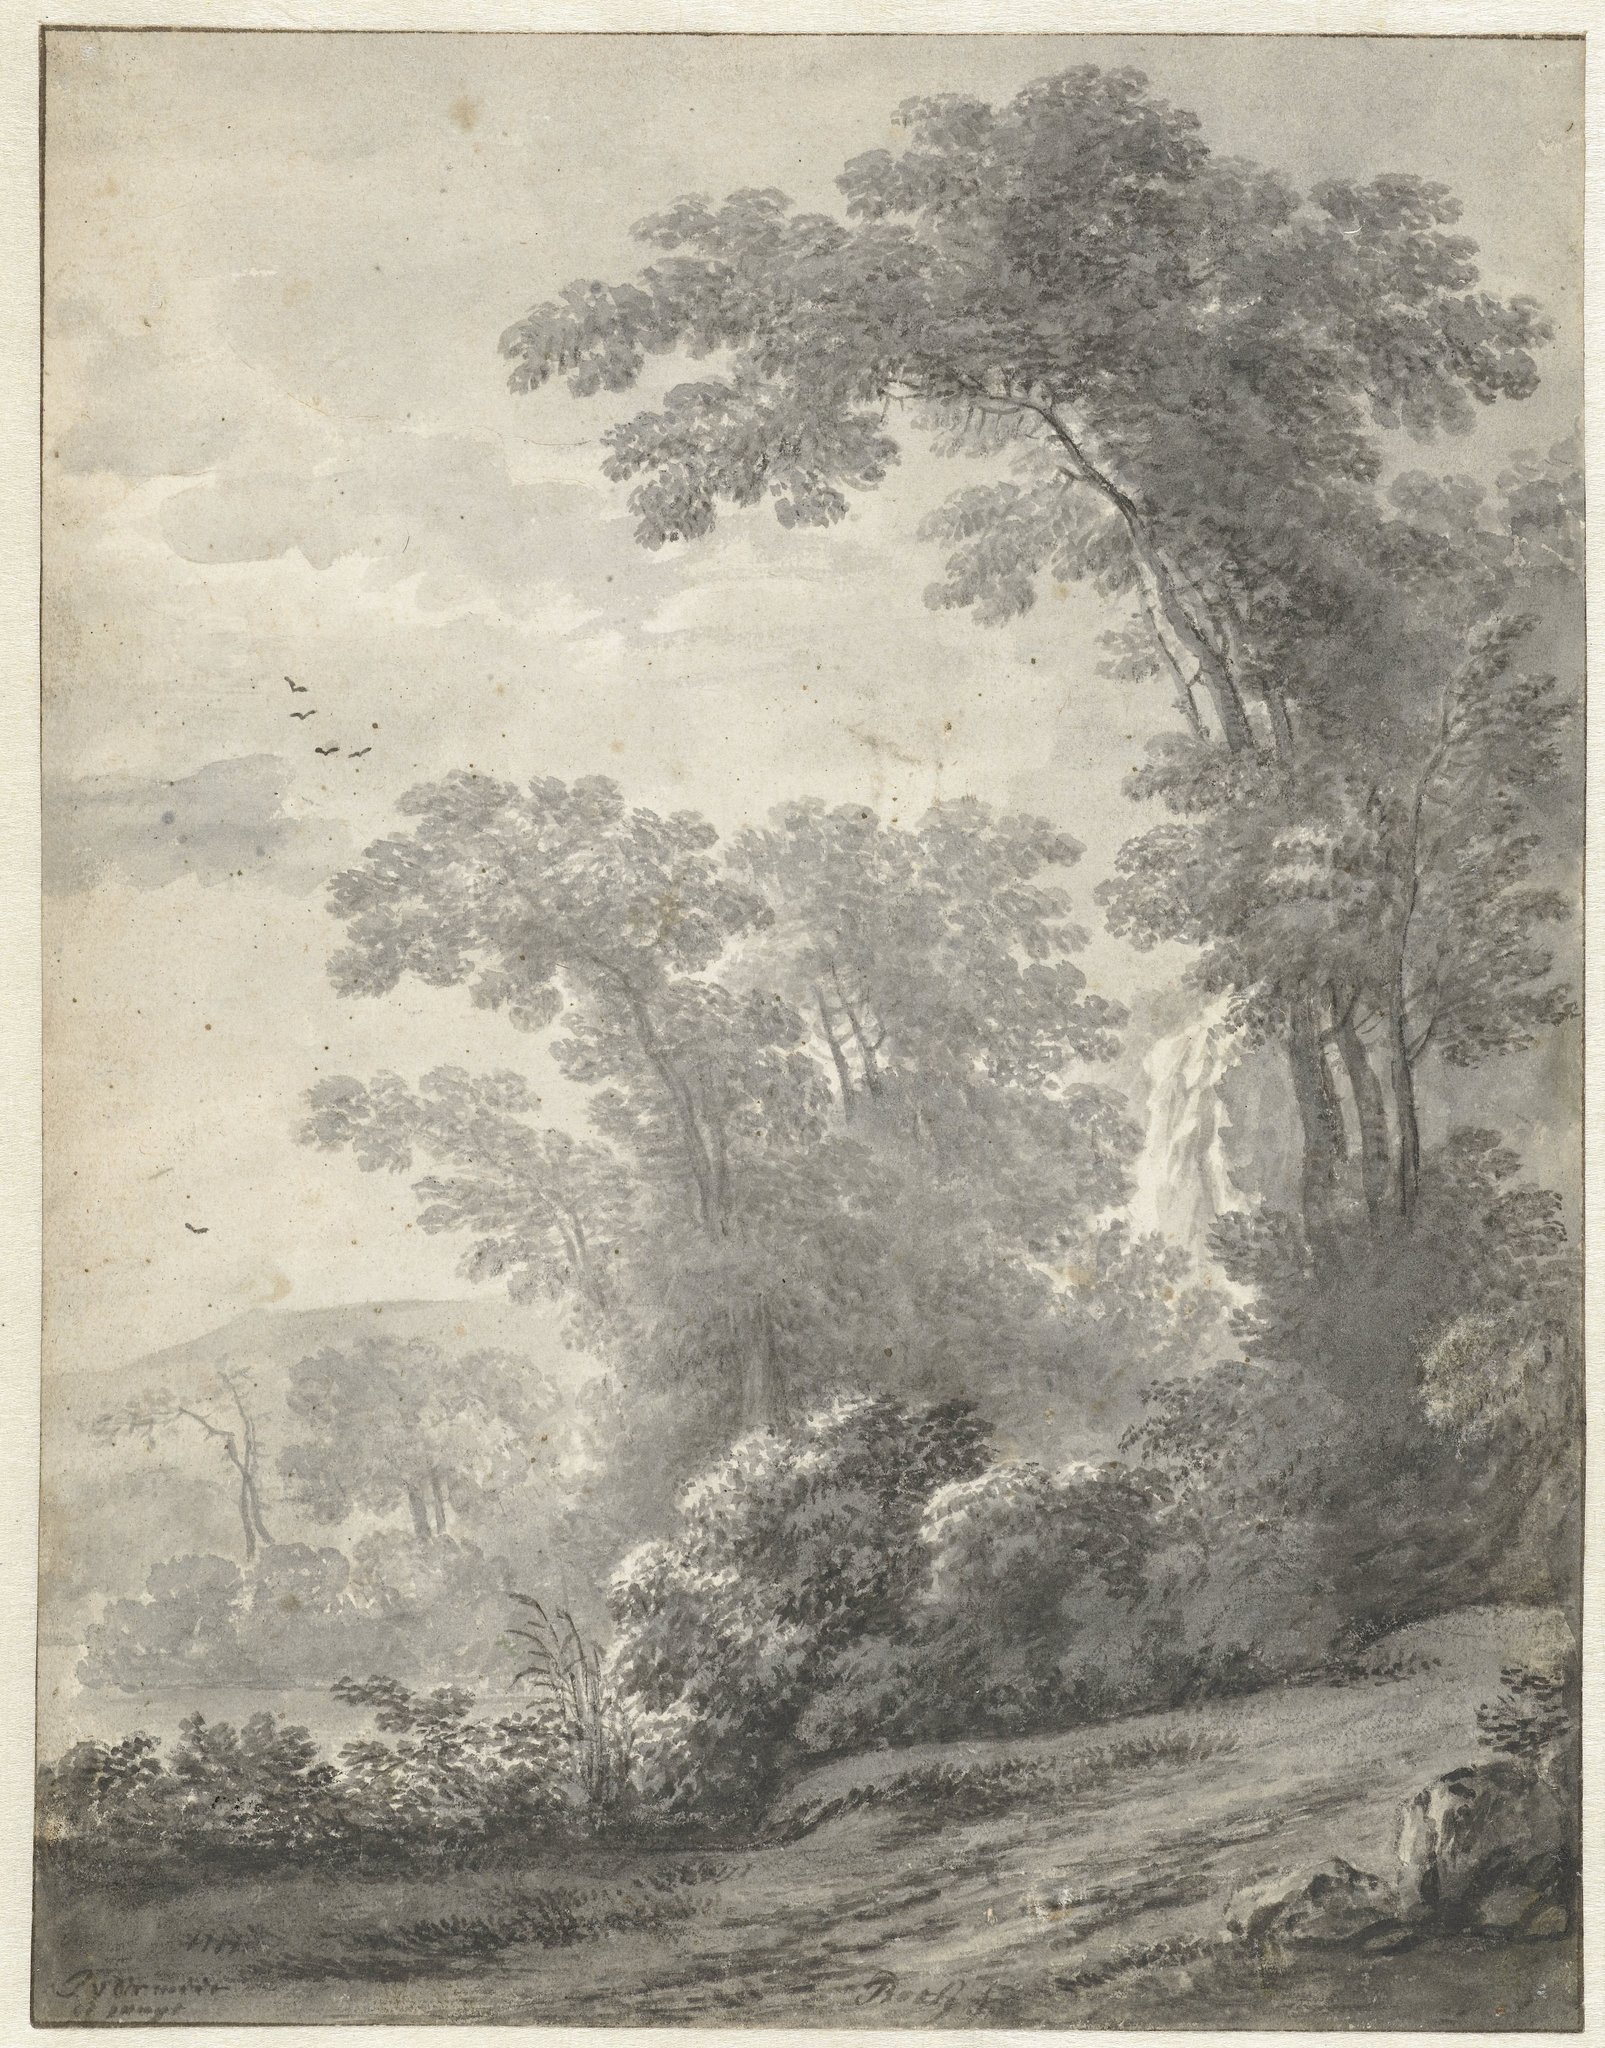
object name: drawing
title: Mountain Landscape with Trees near a River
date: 1700-1705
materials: chalk, graphite, ink, paper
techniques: brush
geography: haarlem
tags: forest, wood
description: Berglandschap met op de voorgrond een pad.